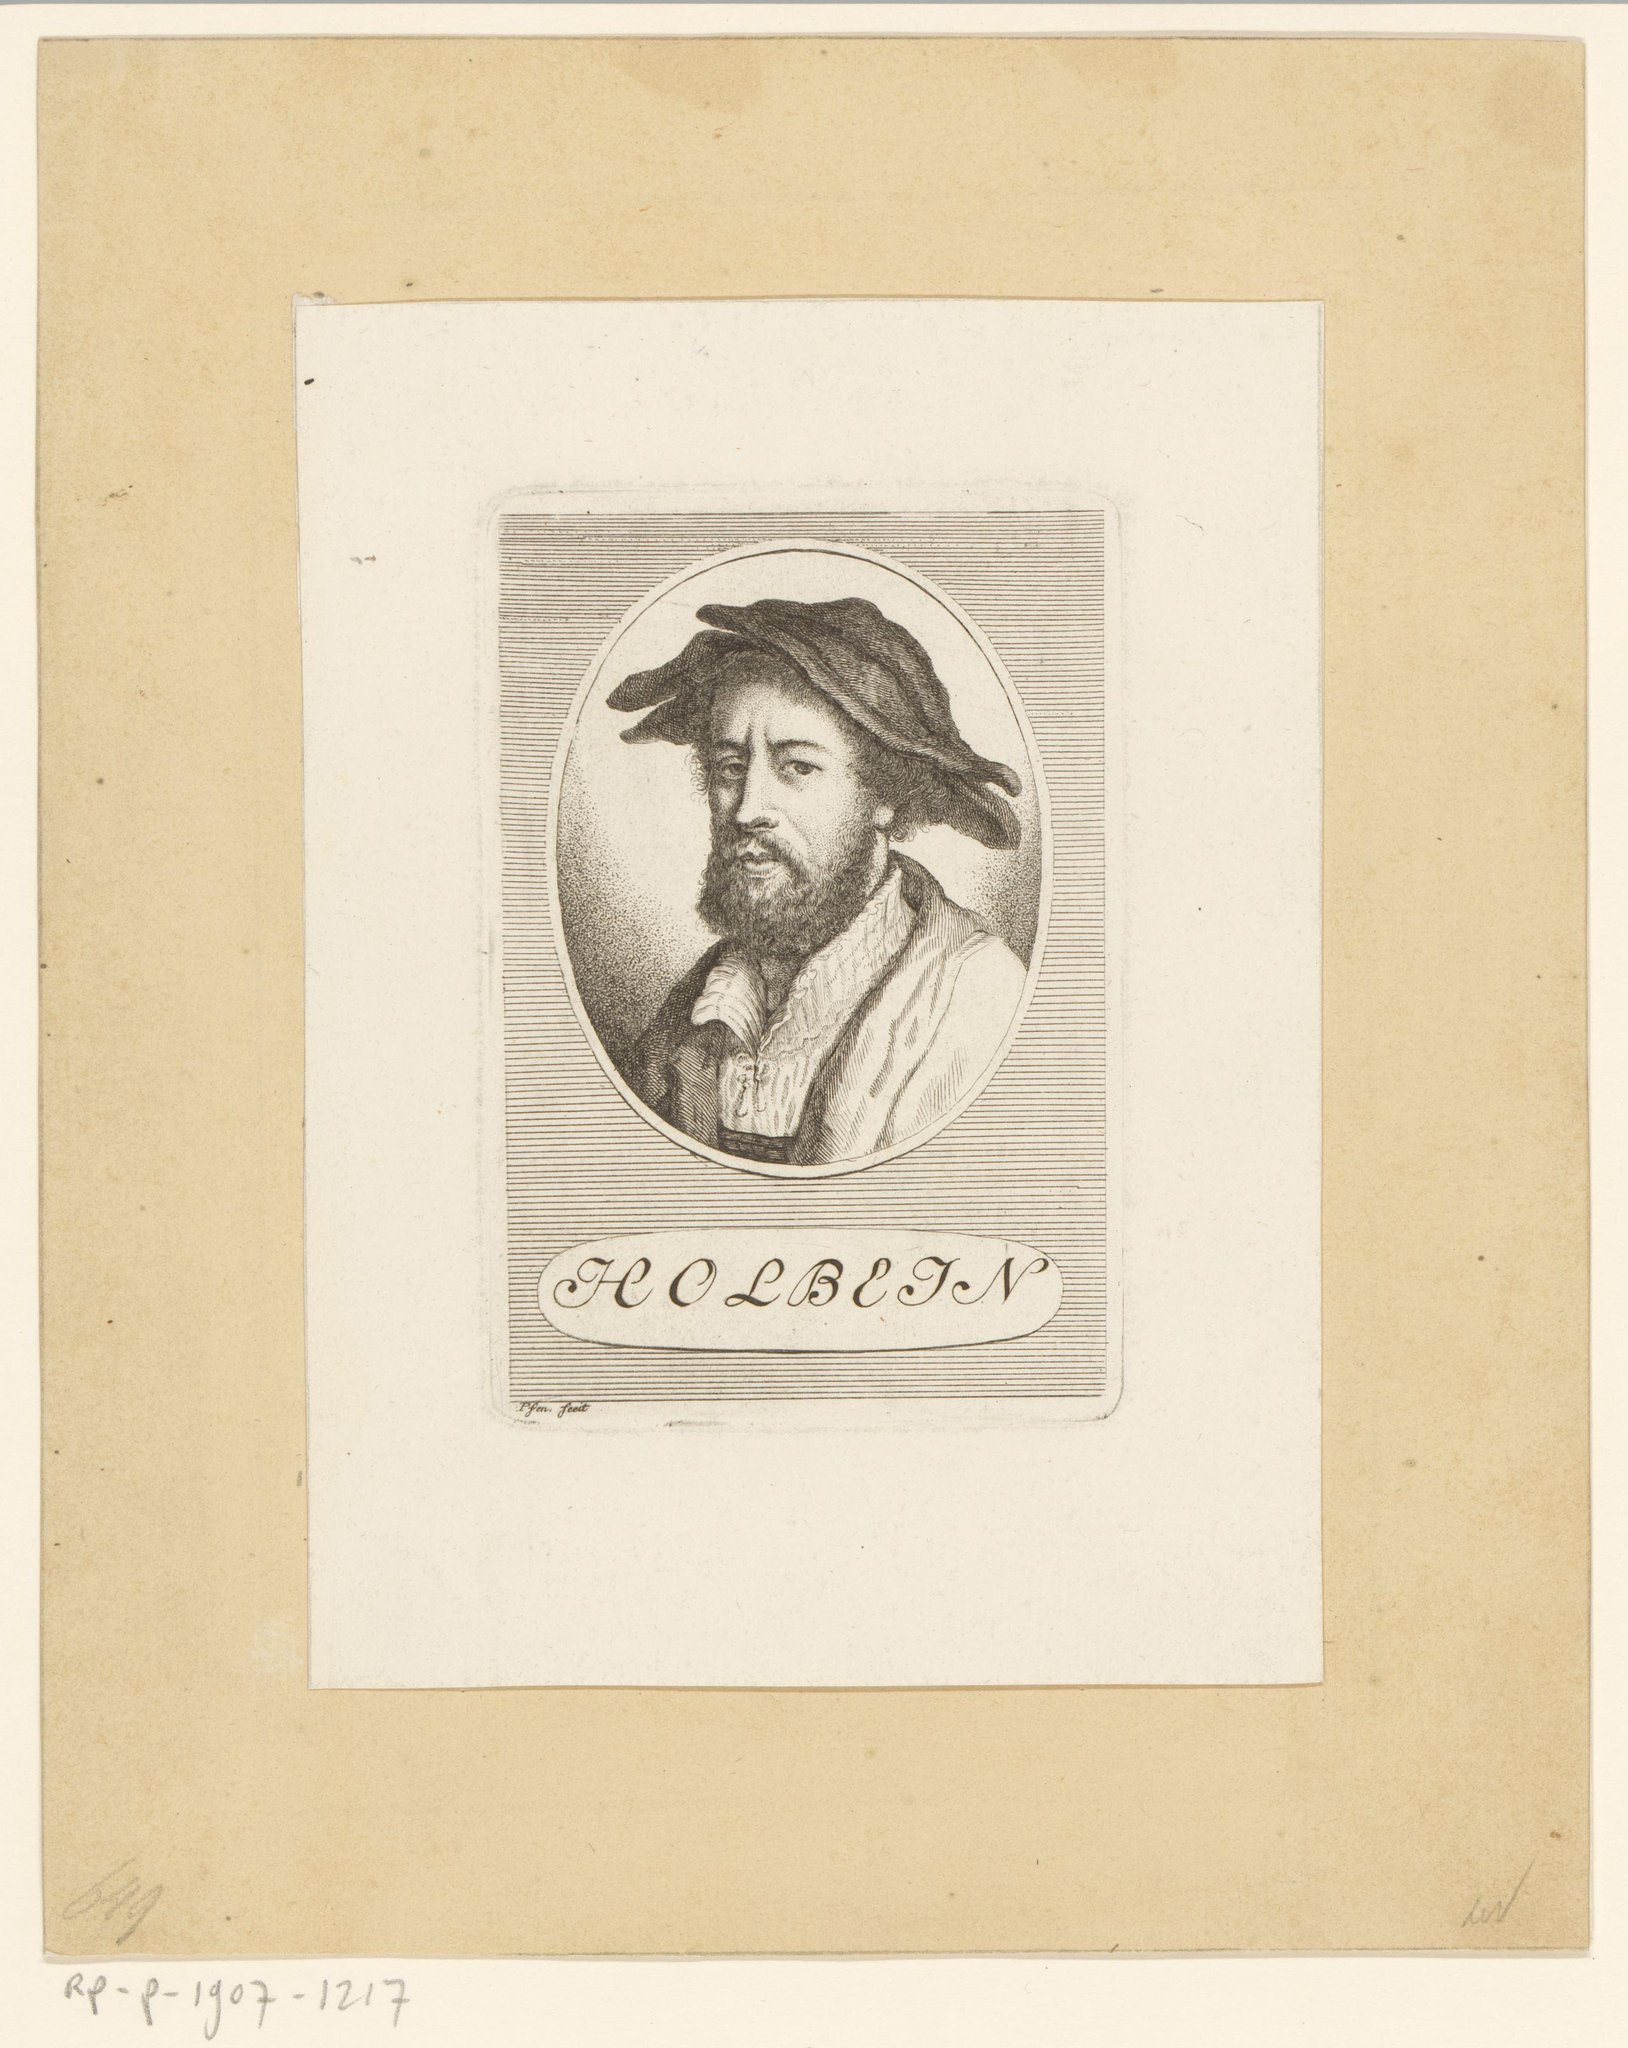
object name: print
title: Portret van Hans Holbein (I)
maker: heinrich pfenninger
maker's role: print maker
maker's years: 1749-1815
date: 1759-1815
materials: paper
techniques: etching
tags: augsburg, painter, hans holbein (i), historical persons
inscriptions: collector's mark: Lugt 2228